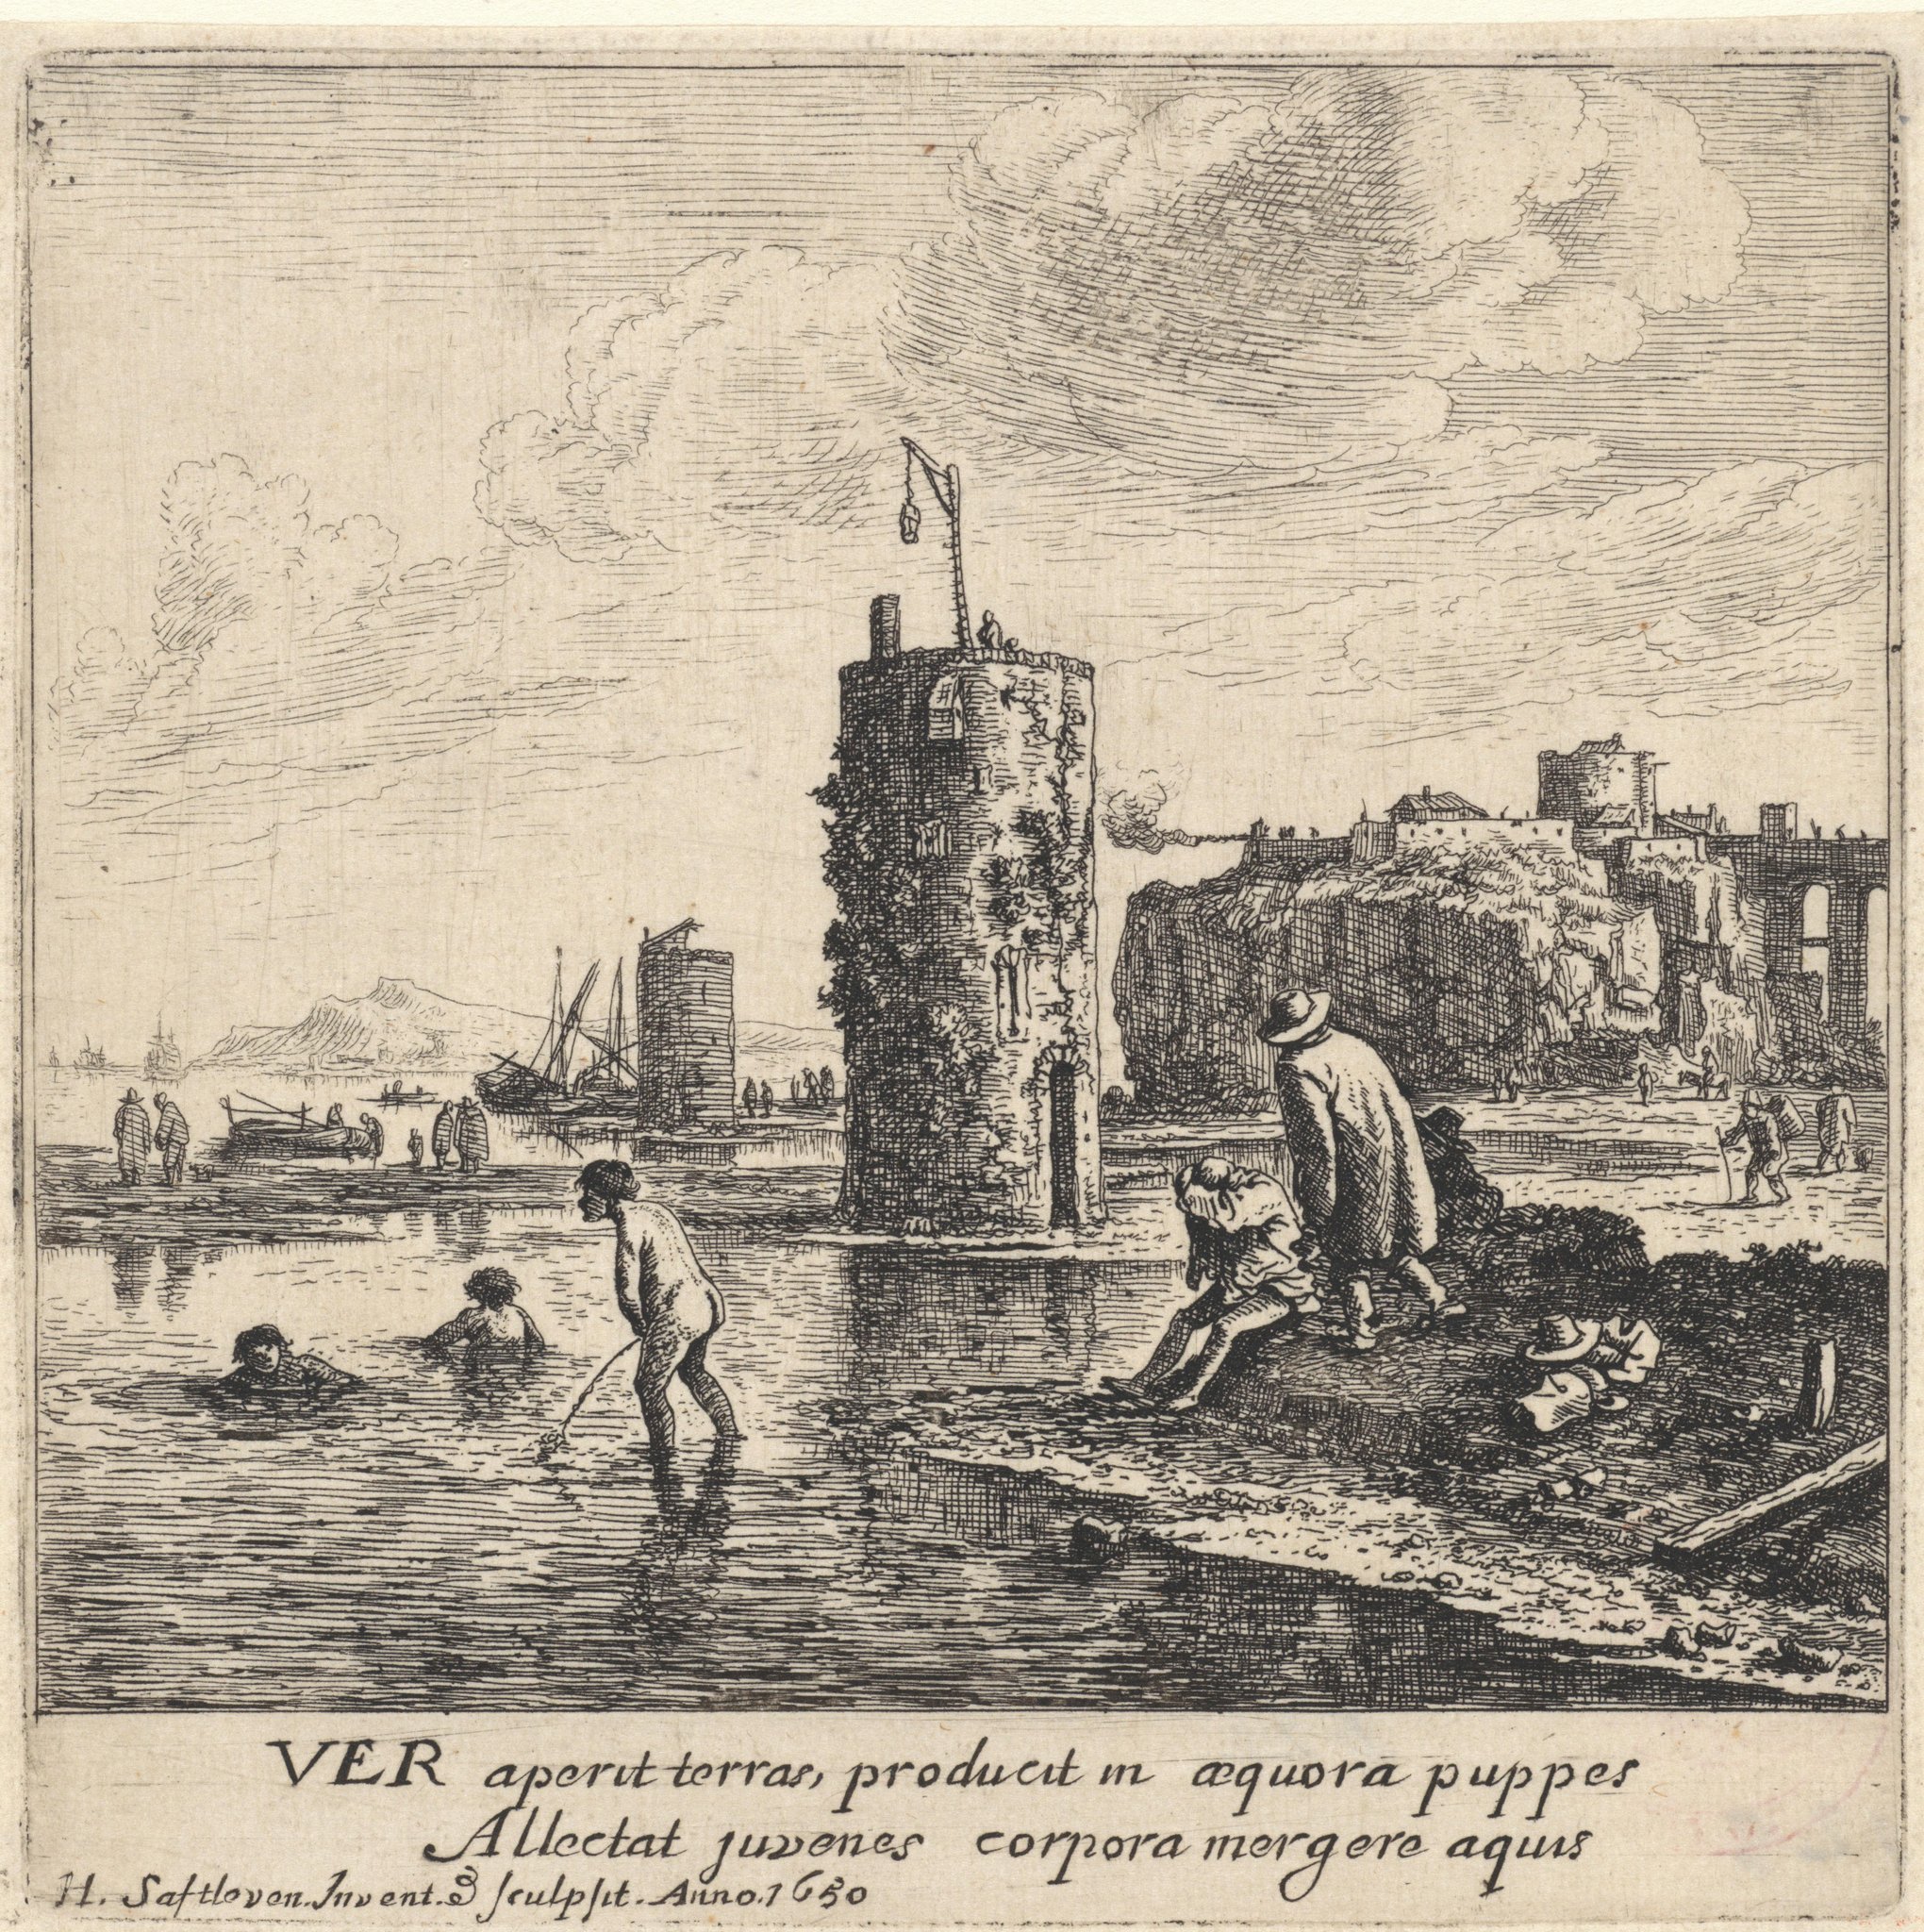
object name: print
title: Lente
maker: herman saftleven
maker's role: draughtsman, painter, print maker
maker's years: 1609-1685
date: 1650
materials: paper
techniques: etching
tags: landscape with tower or castle, swimming (movement in water), urination, spring landscape; landscape symbolizing spring (the four seasons of the year)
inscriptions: collector's mark: Lugt 240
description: Gezicht op een rivierlandschap waar enkele figuren een bad in de rivier nemen, terwijl een naakte man in hetzelfde water plast. Op de achtergrond een ronde toren, figuren en schepen. Voorstelling van de lente uit een serie van de vier seizoenen.